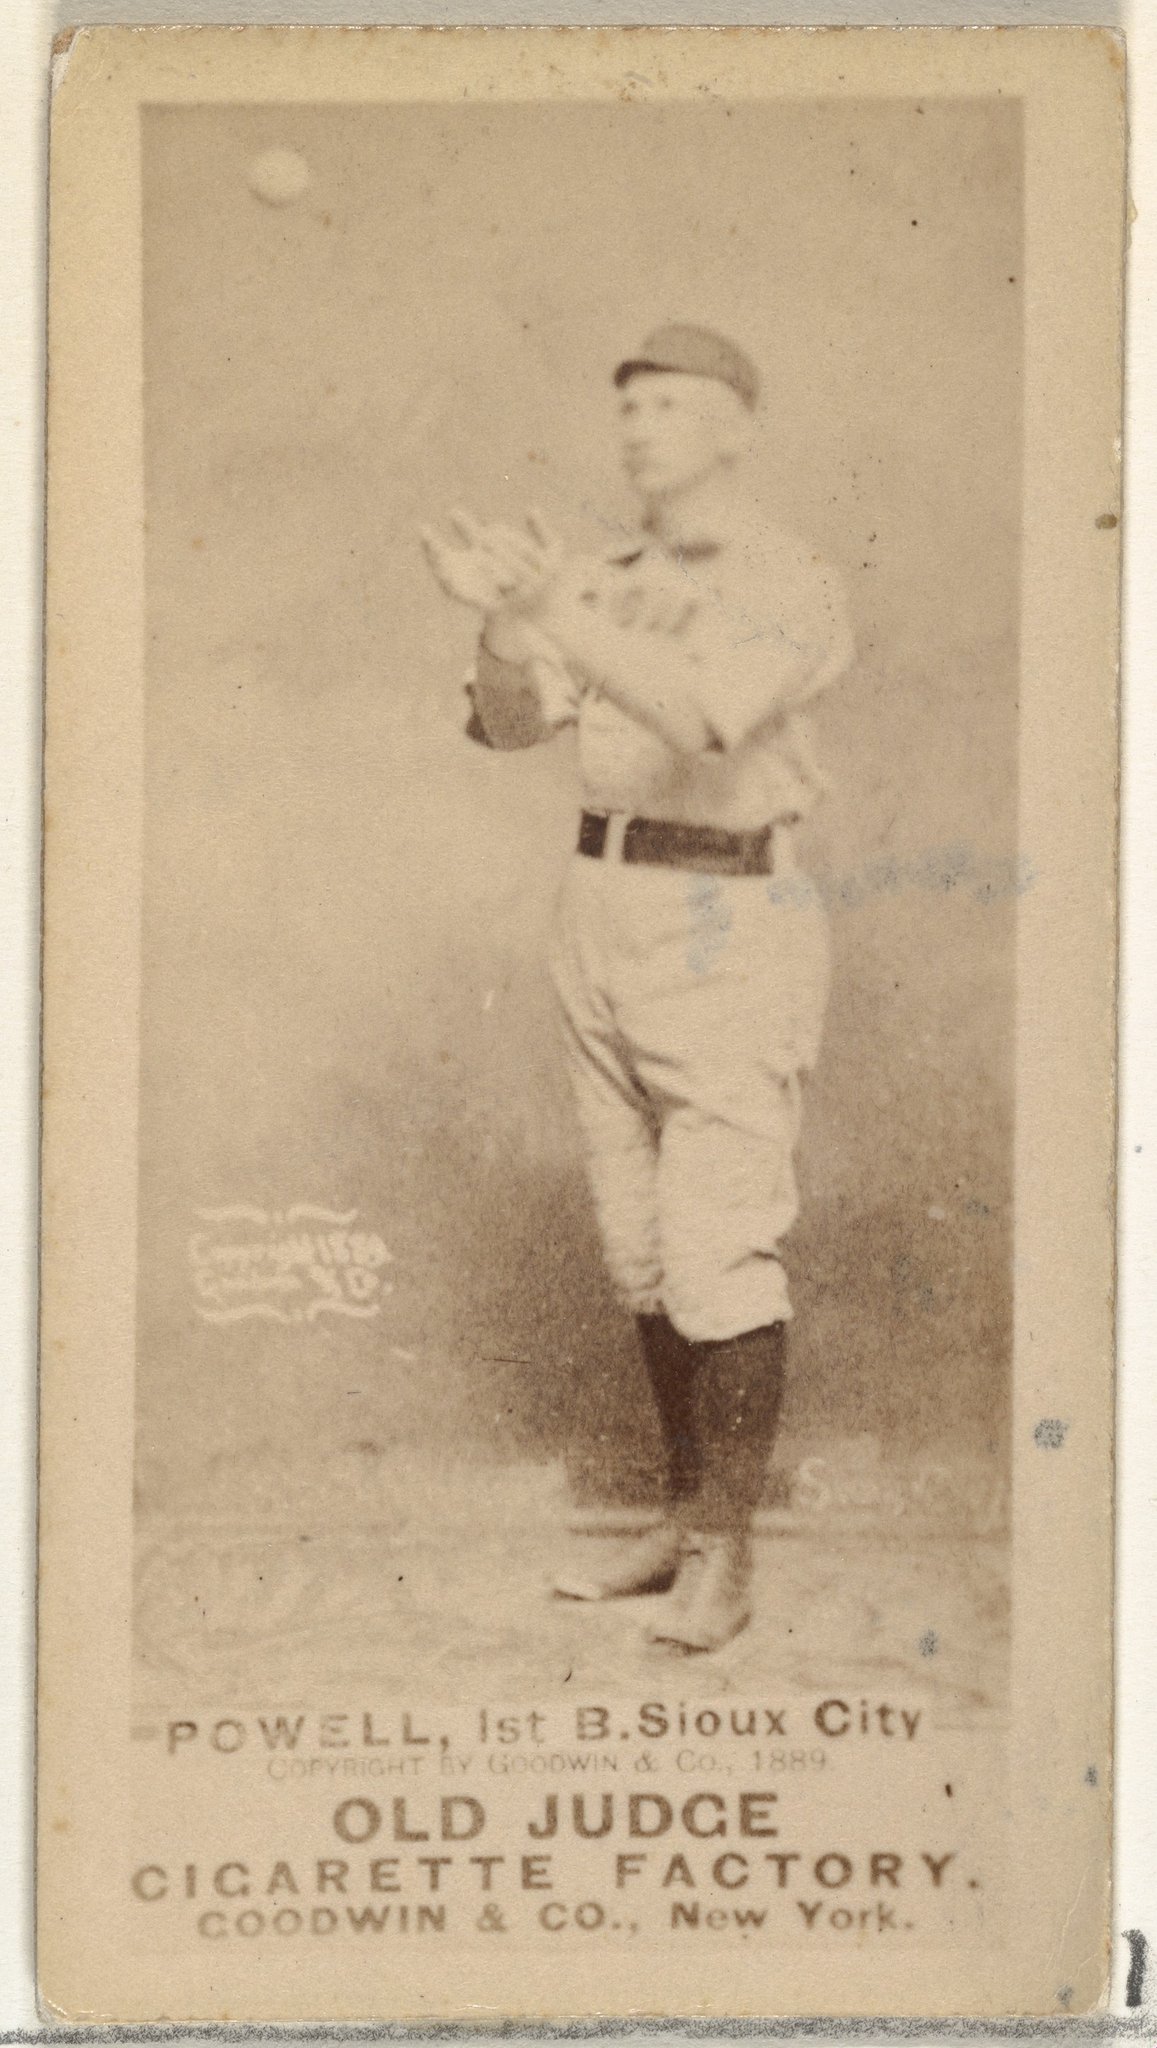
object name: baseball card, photograph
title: James Edwin "Jim" Powell, Manager and 1st Base, Sioux City Corn Huskers, from the Old Judge series (N172) for Old Judge Cigarettes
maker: goodwin & company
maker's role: publisher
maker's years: 1850-1950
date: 1889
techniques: albumen silver print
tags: men,portraits,baseball,athletes